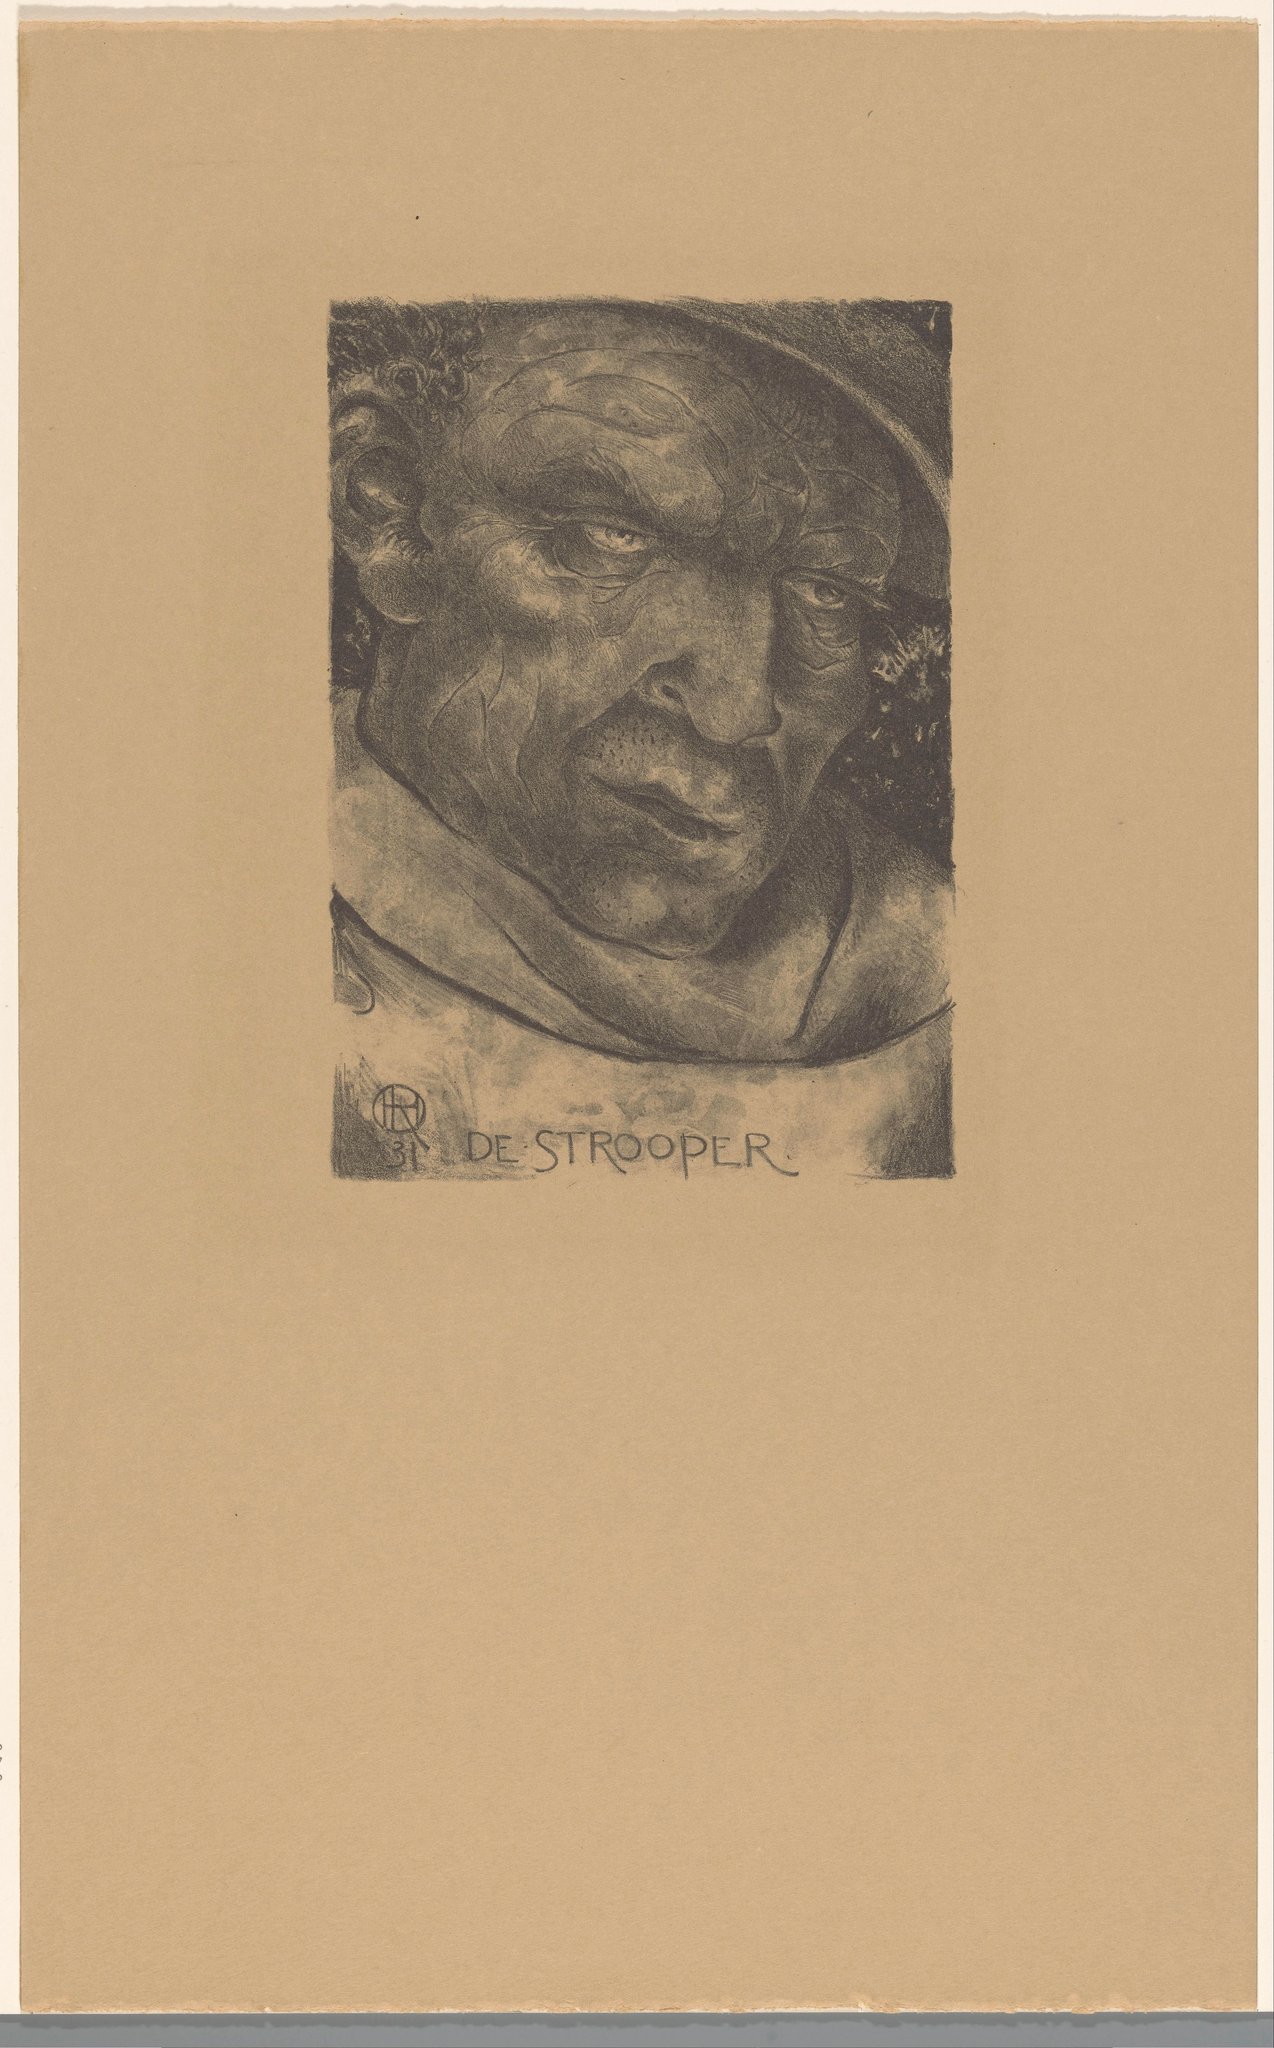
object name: print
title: Brabantse types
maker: richard nicolaüs roland holst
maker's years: 1868-1938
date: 1931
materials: paper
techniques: lithograph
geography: buissche heide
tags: head (human), poacher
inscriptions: collector's mark: Lugt 2228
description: Een man met stoppelbaard en hoofddeksel.